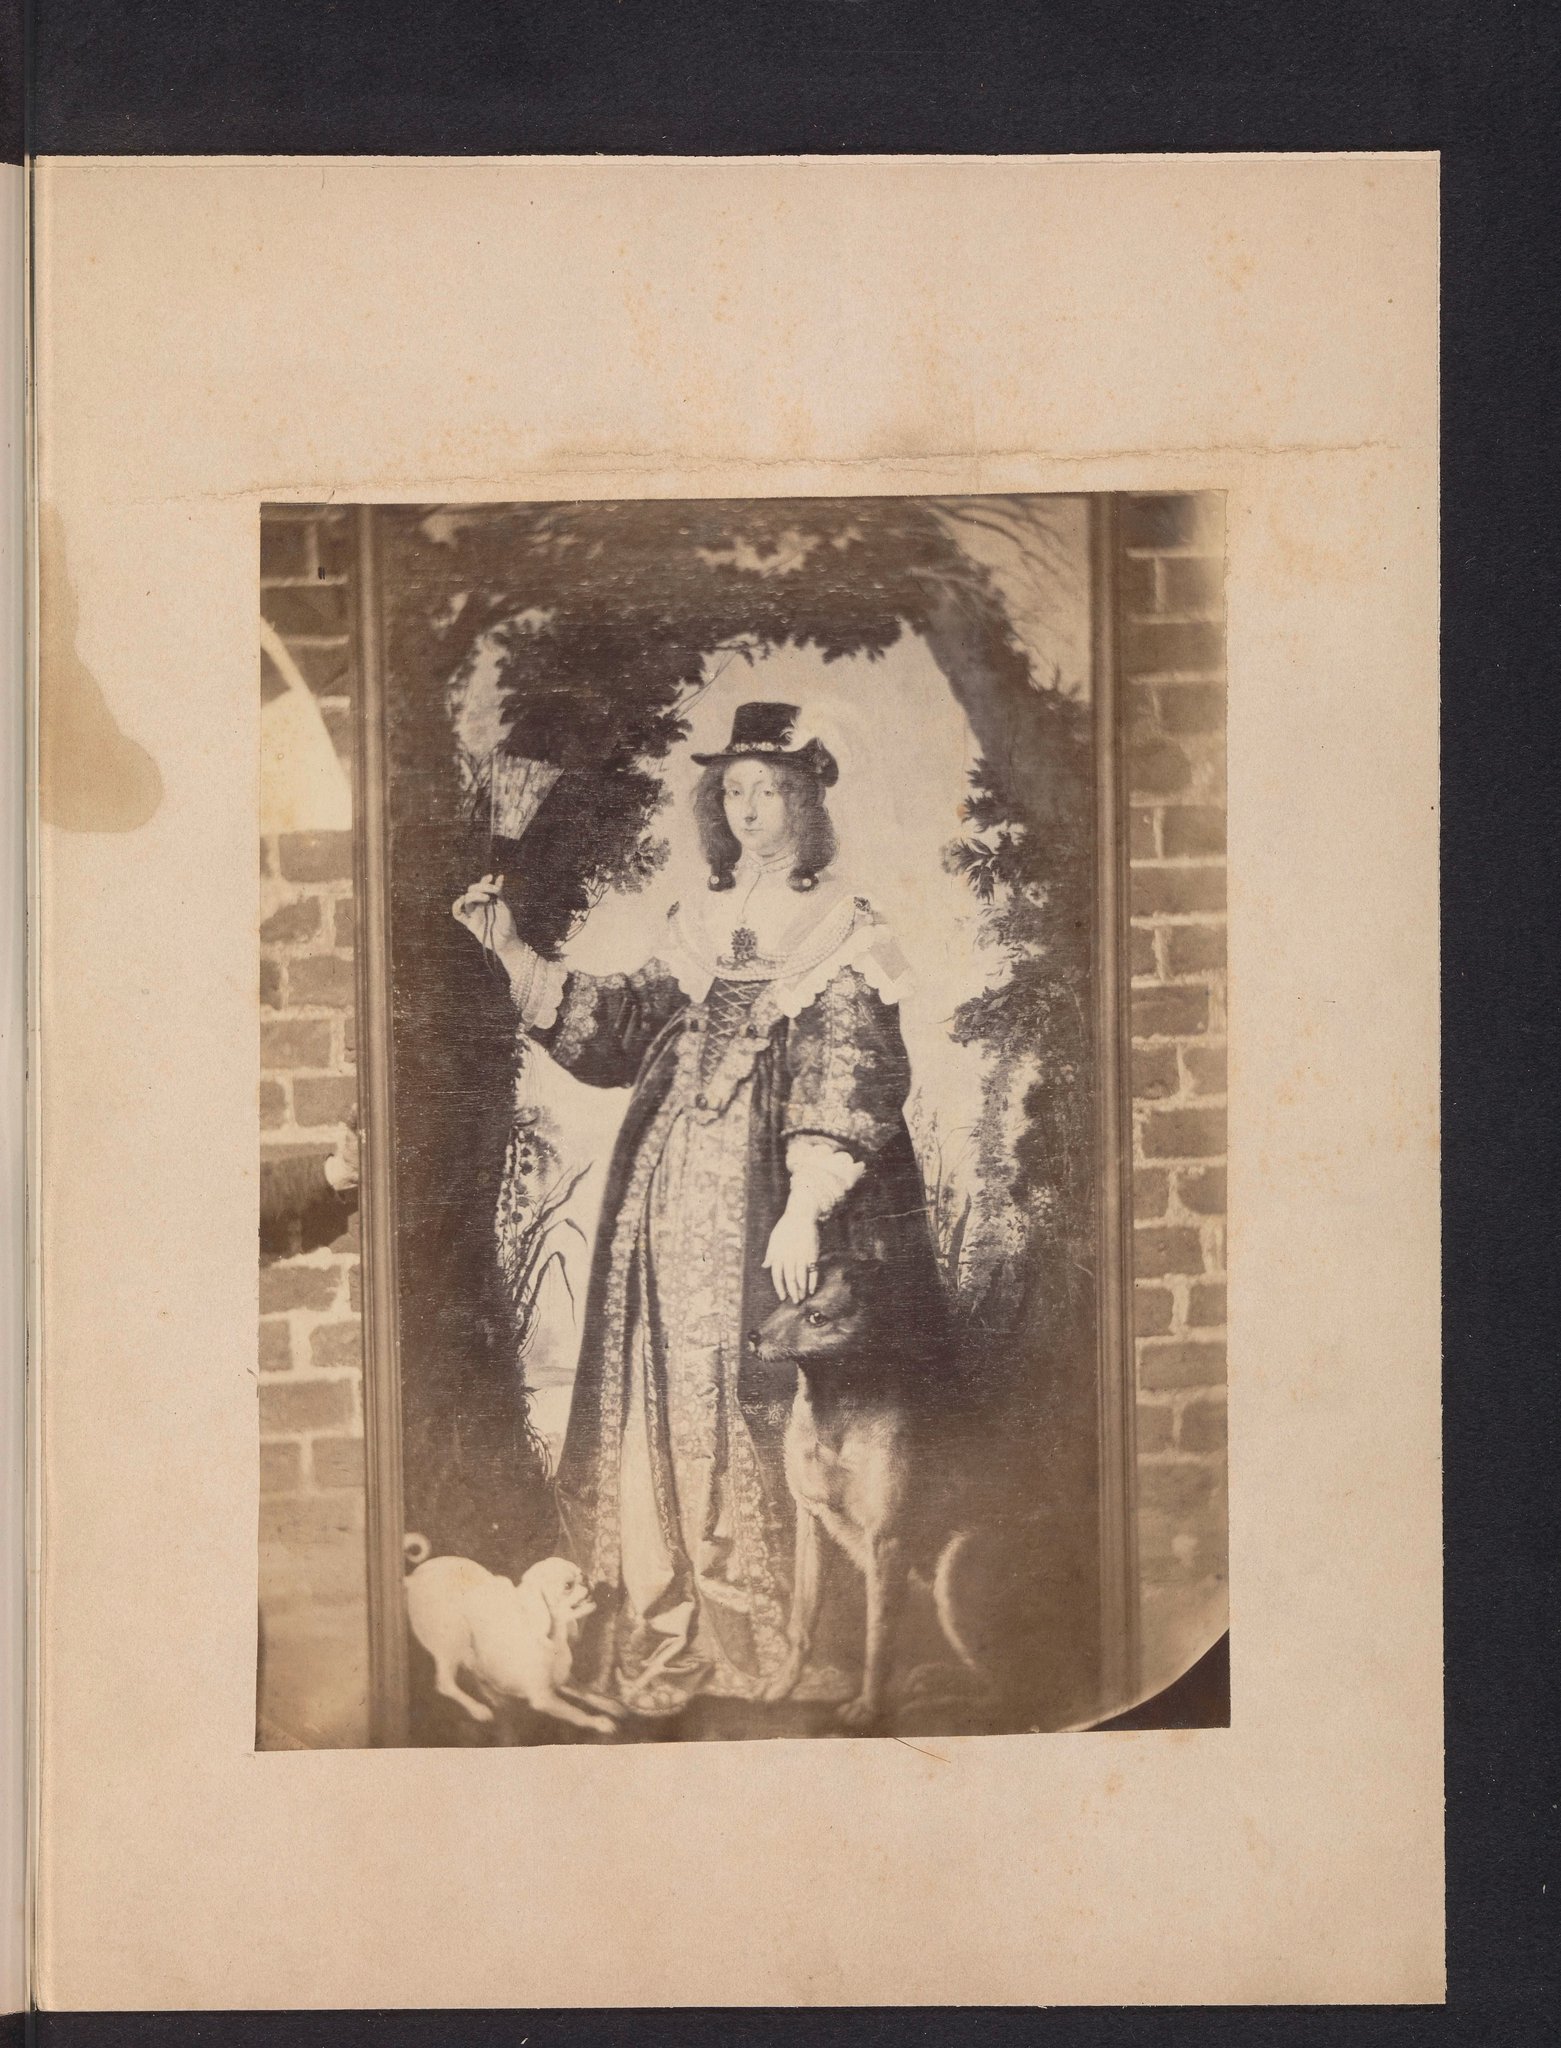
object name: photograph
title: Fotoreproductie van een schilderij, voorstellende een portret van Leonora Christina Ulfeldt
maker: julius wulff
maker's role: fotograaf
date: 1858-1862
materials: photographic support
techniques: albumen print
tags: female royal bastard